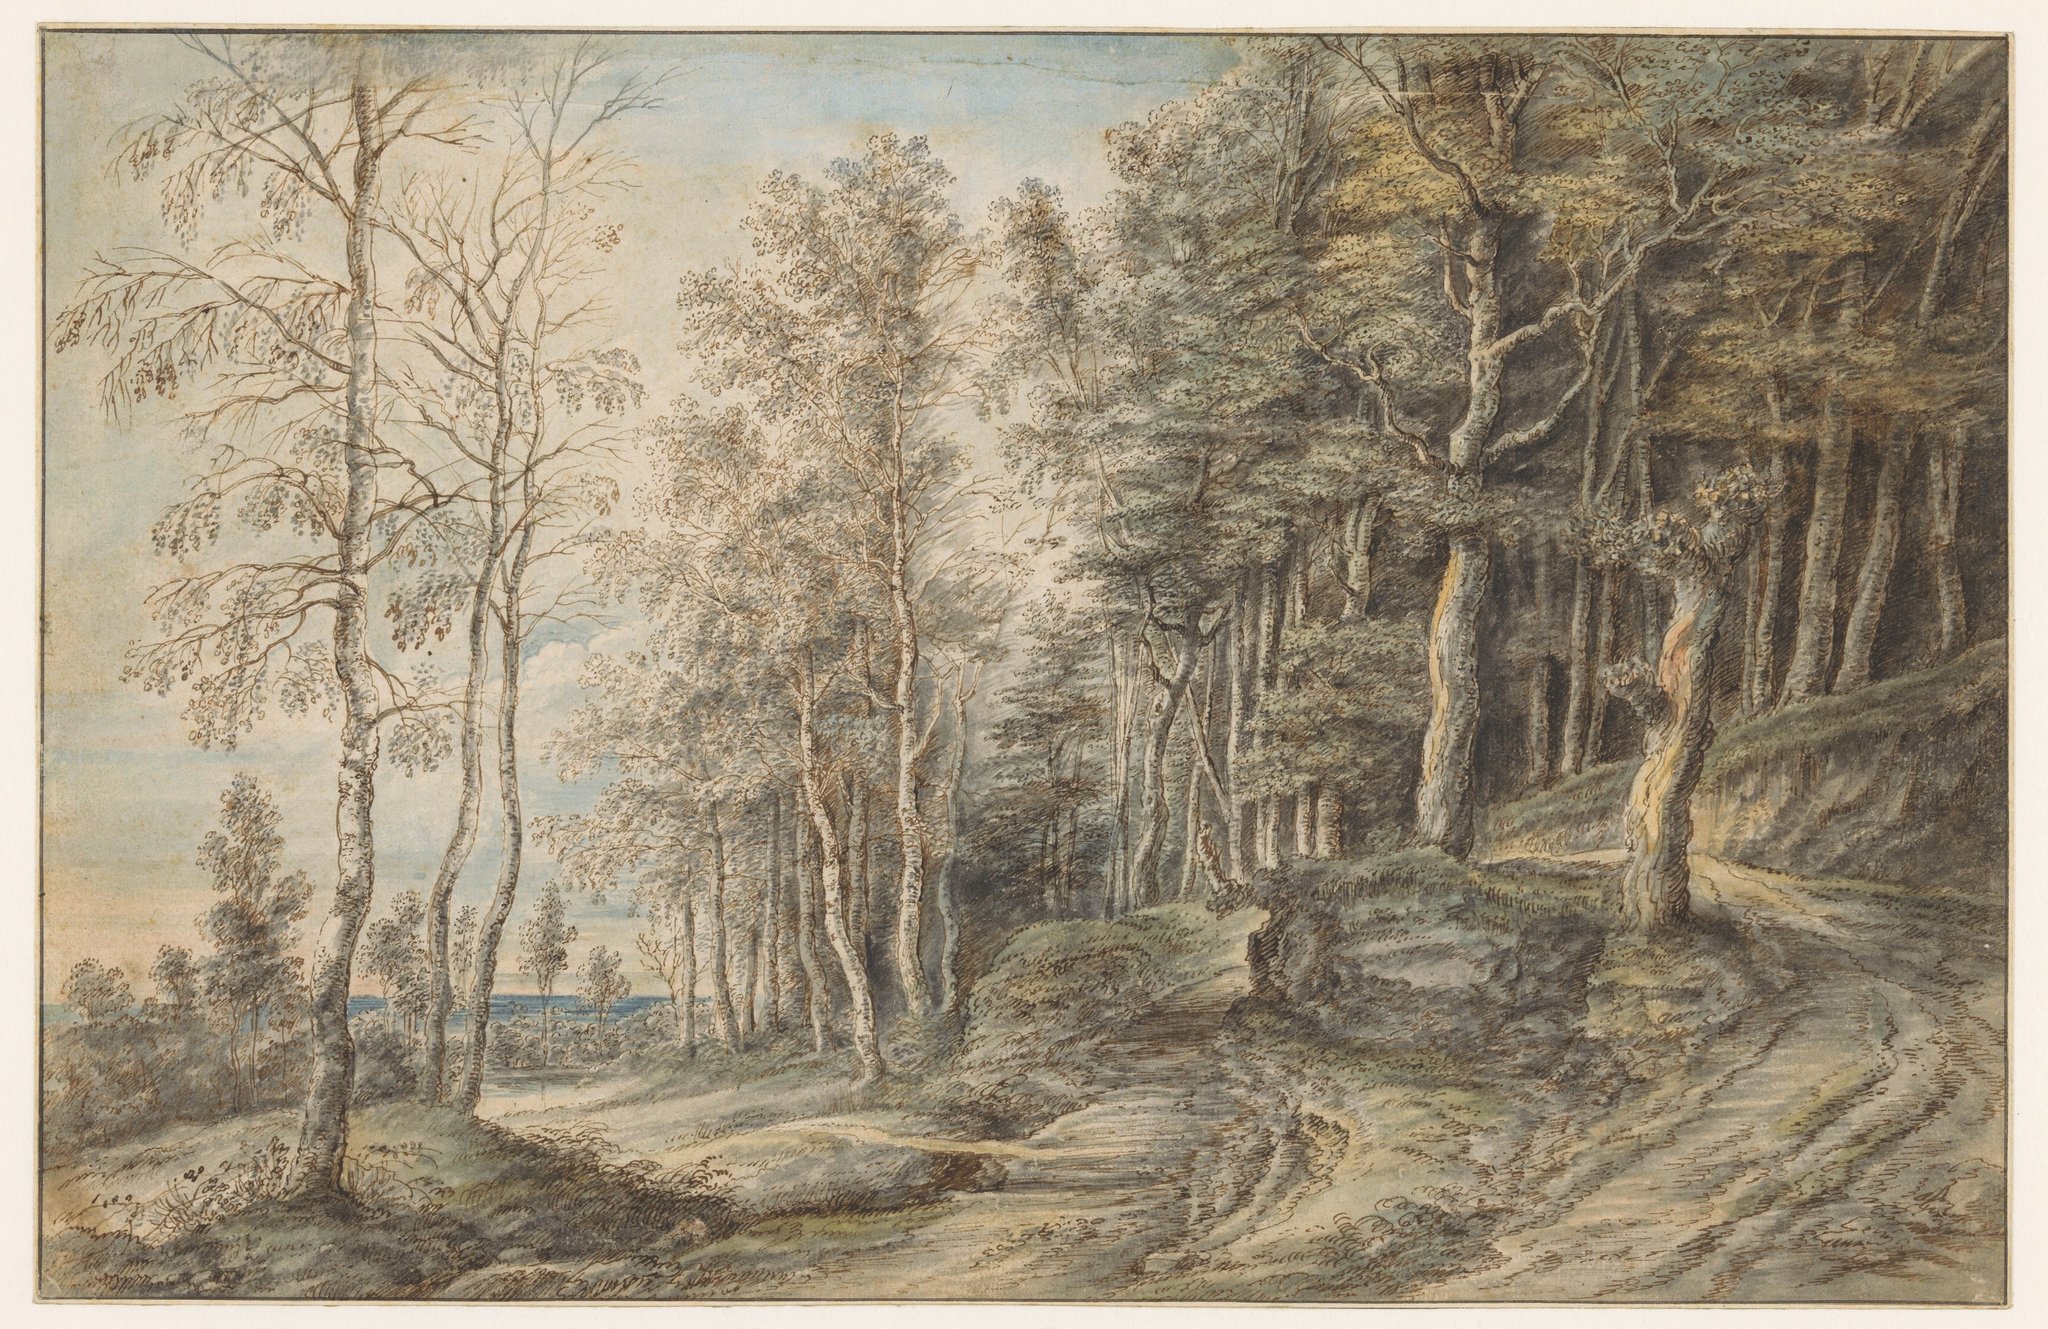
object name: watercolor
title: Boslandschap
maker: lucas van uden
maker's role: draughtsman, print maker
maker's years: 1595-1673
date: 1605-1673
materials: paper, watercolor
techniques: brush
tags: forest, wood